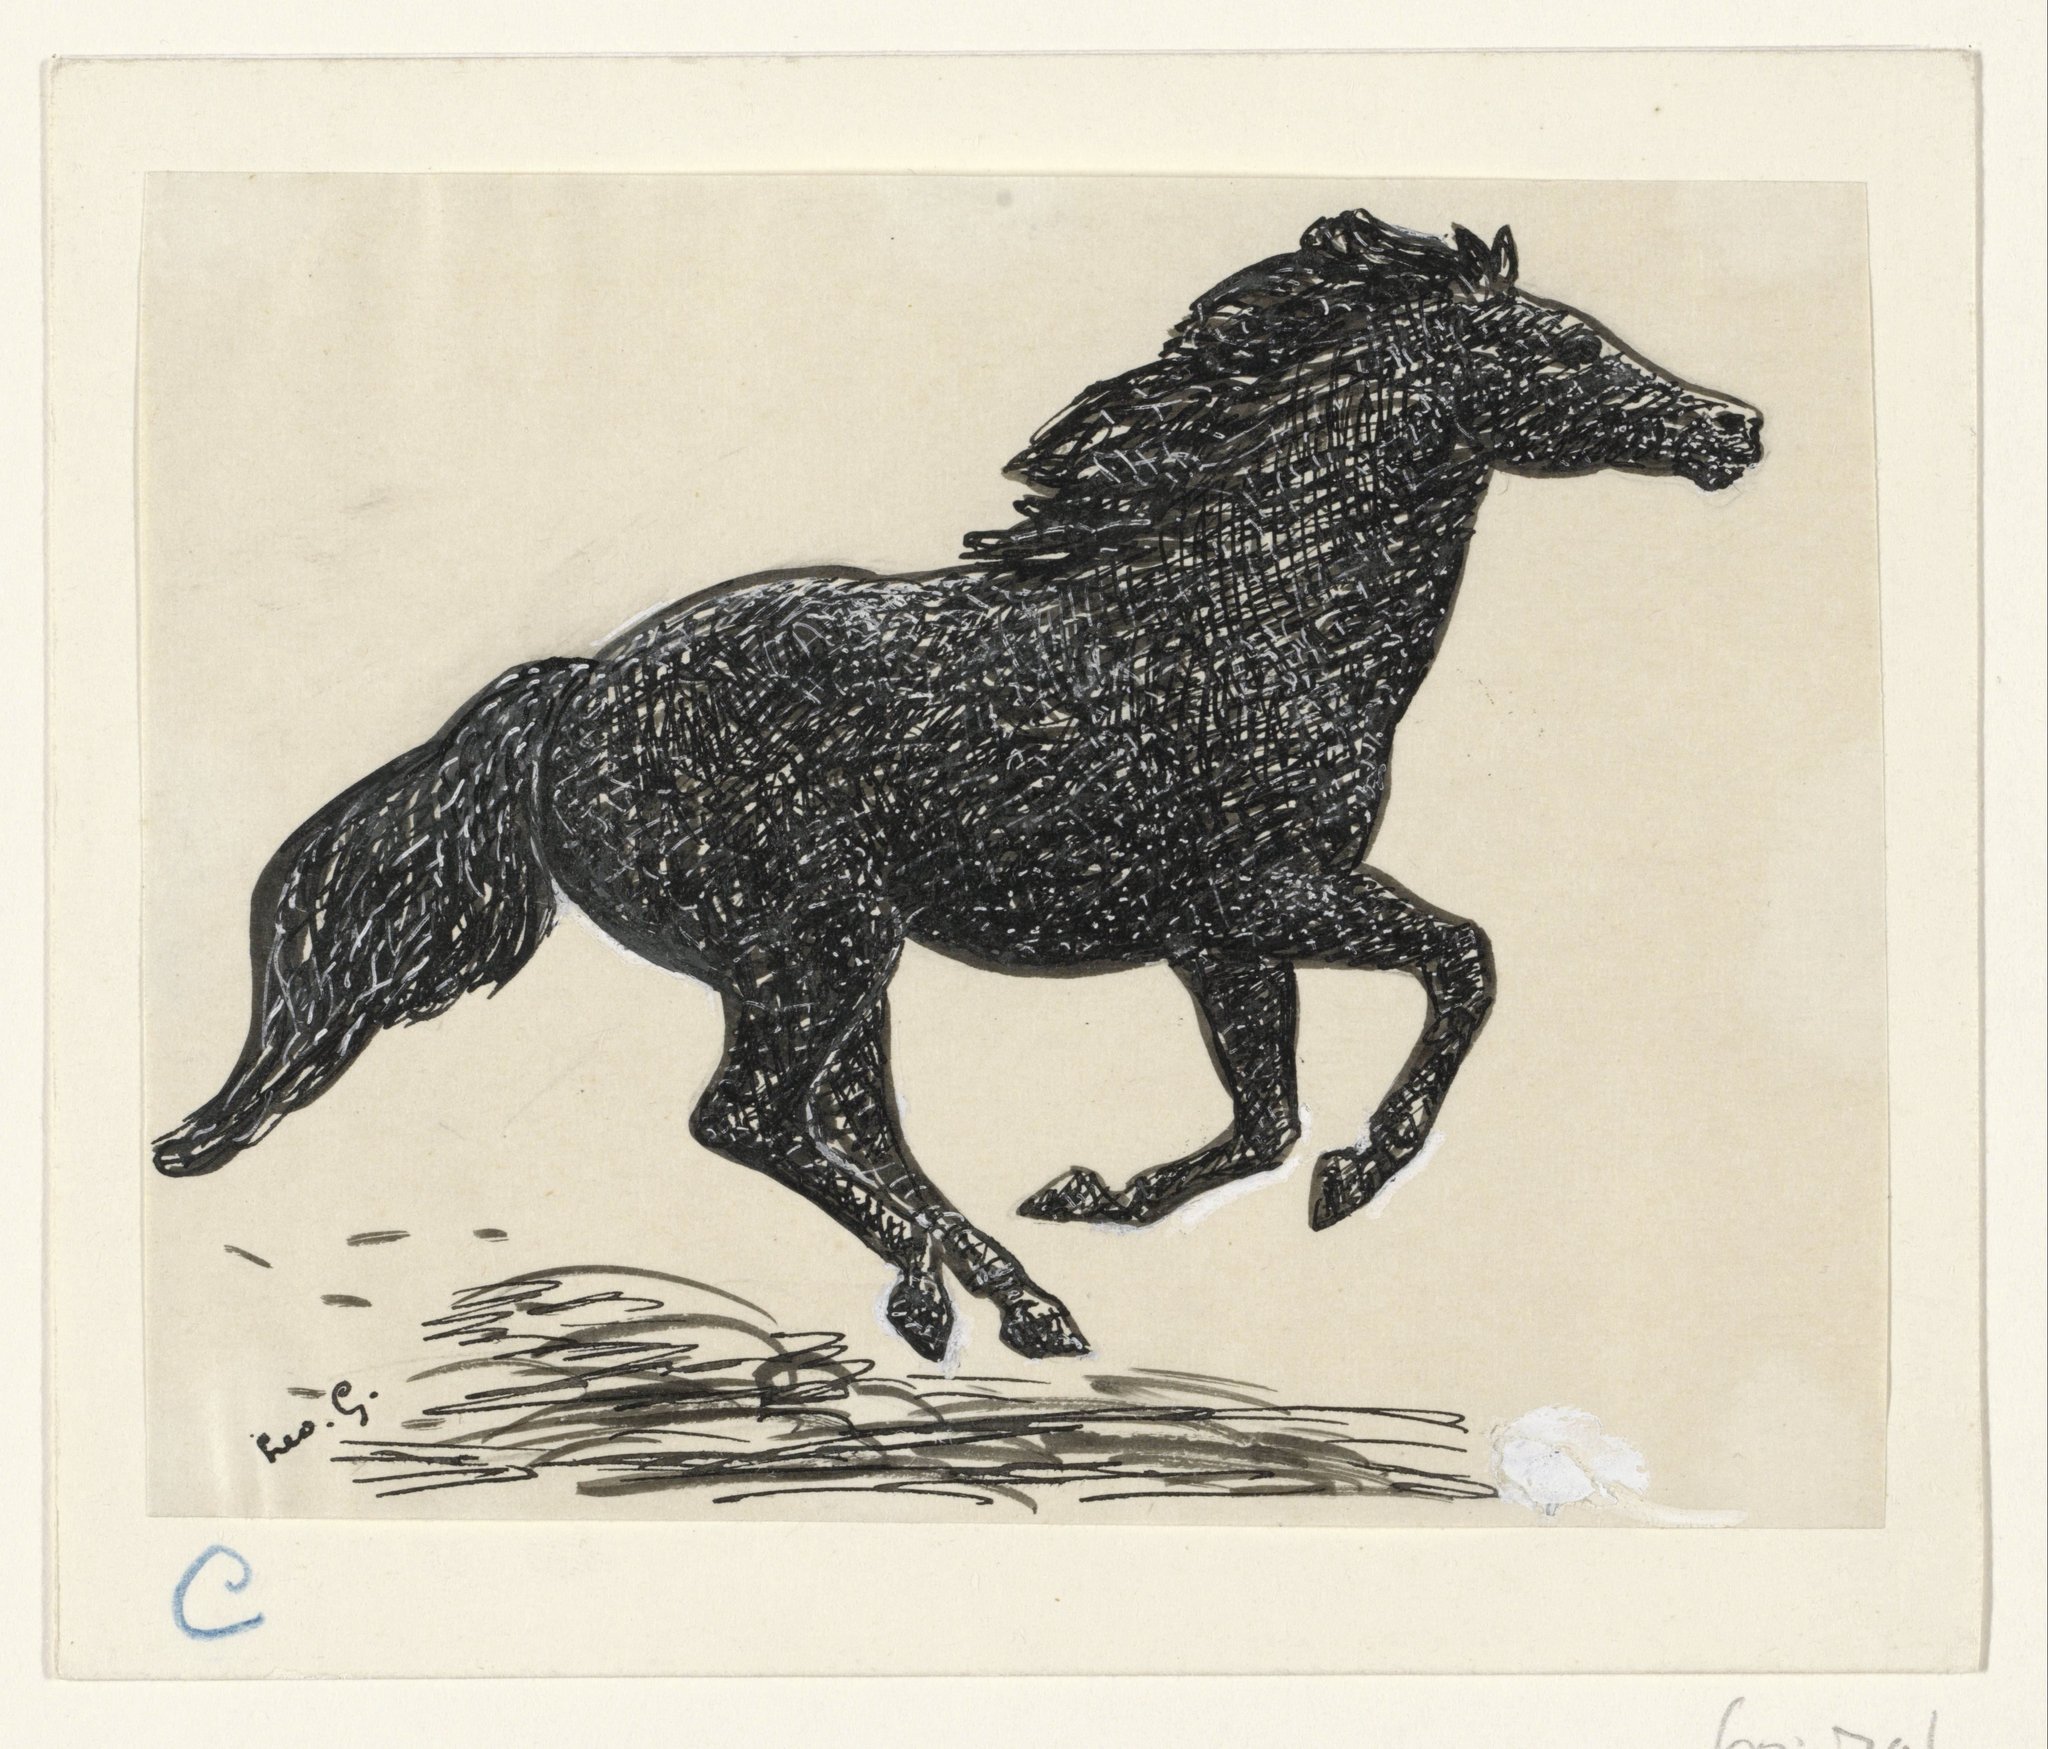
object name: drawing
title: Galopperend paard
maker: leo gestel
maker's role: draughtsman, print maker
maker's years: 1881-1941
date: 1891-1941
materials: paint, ink, paper, pencil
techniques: brush, pen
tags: horse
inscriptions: collector's mark: Lugt 2228